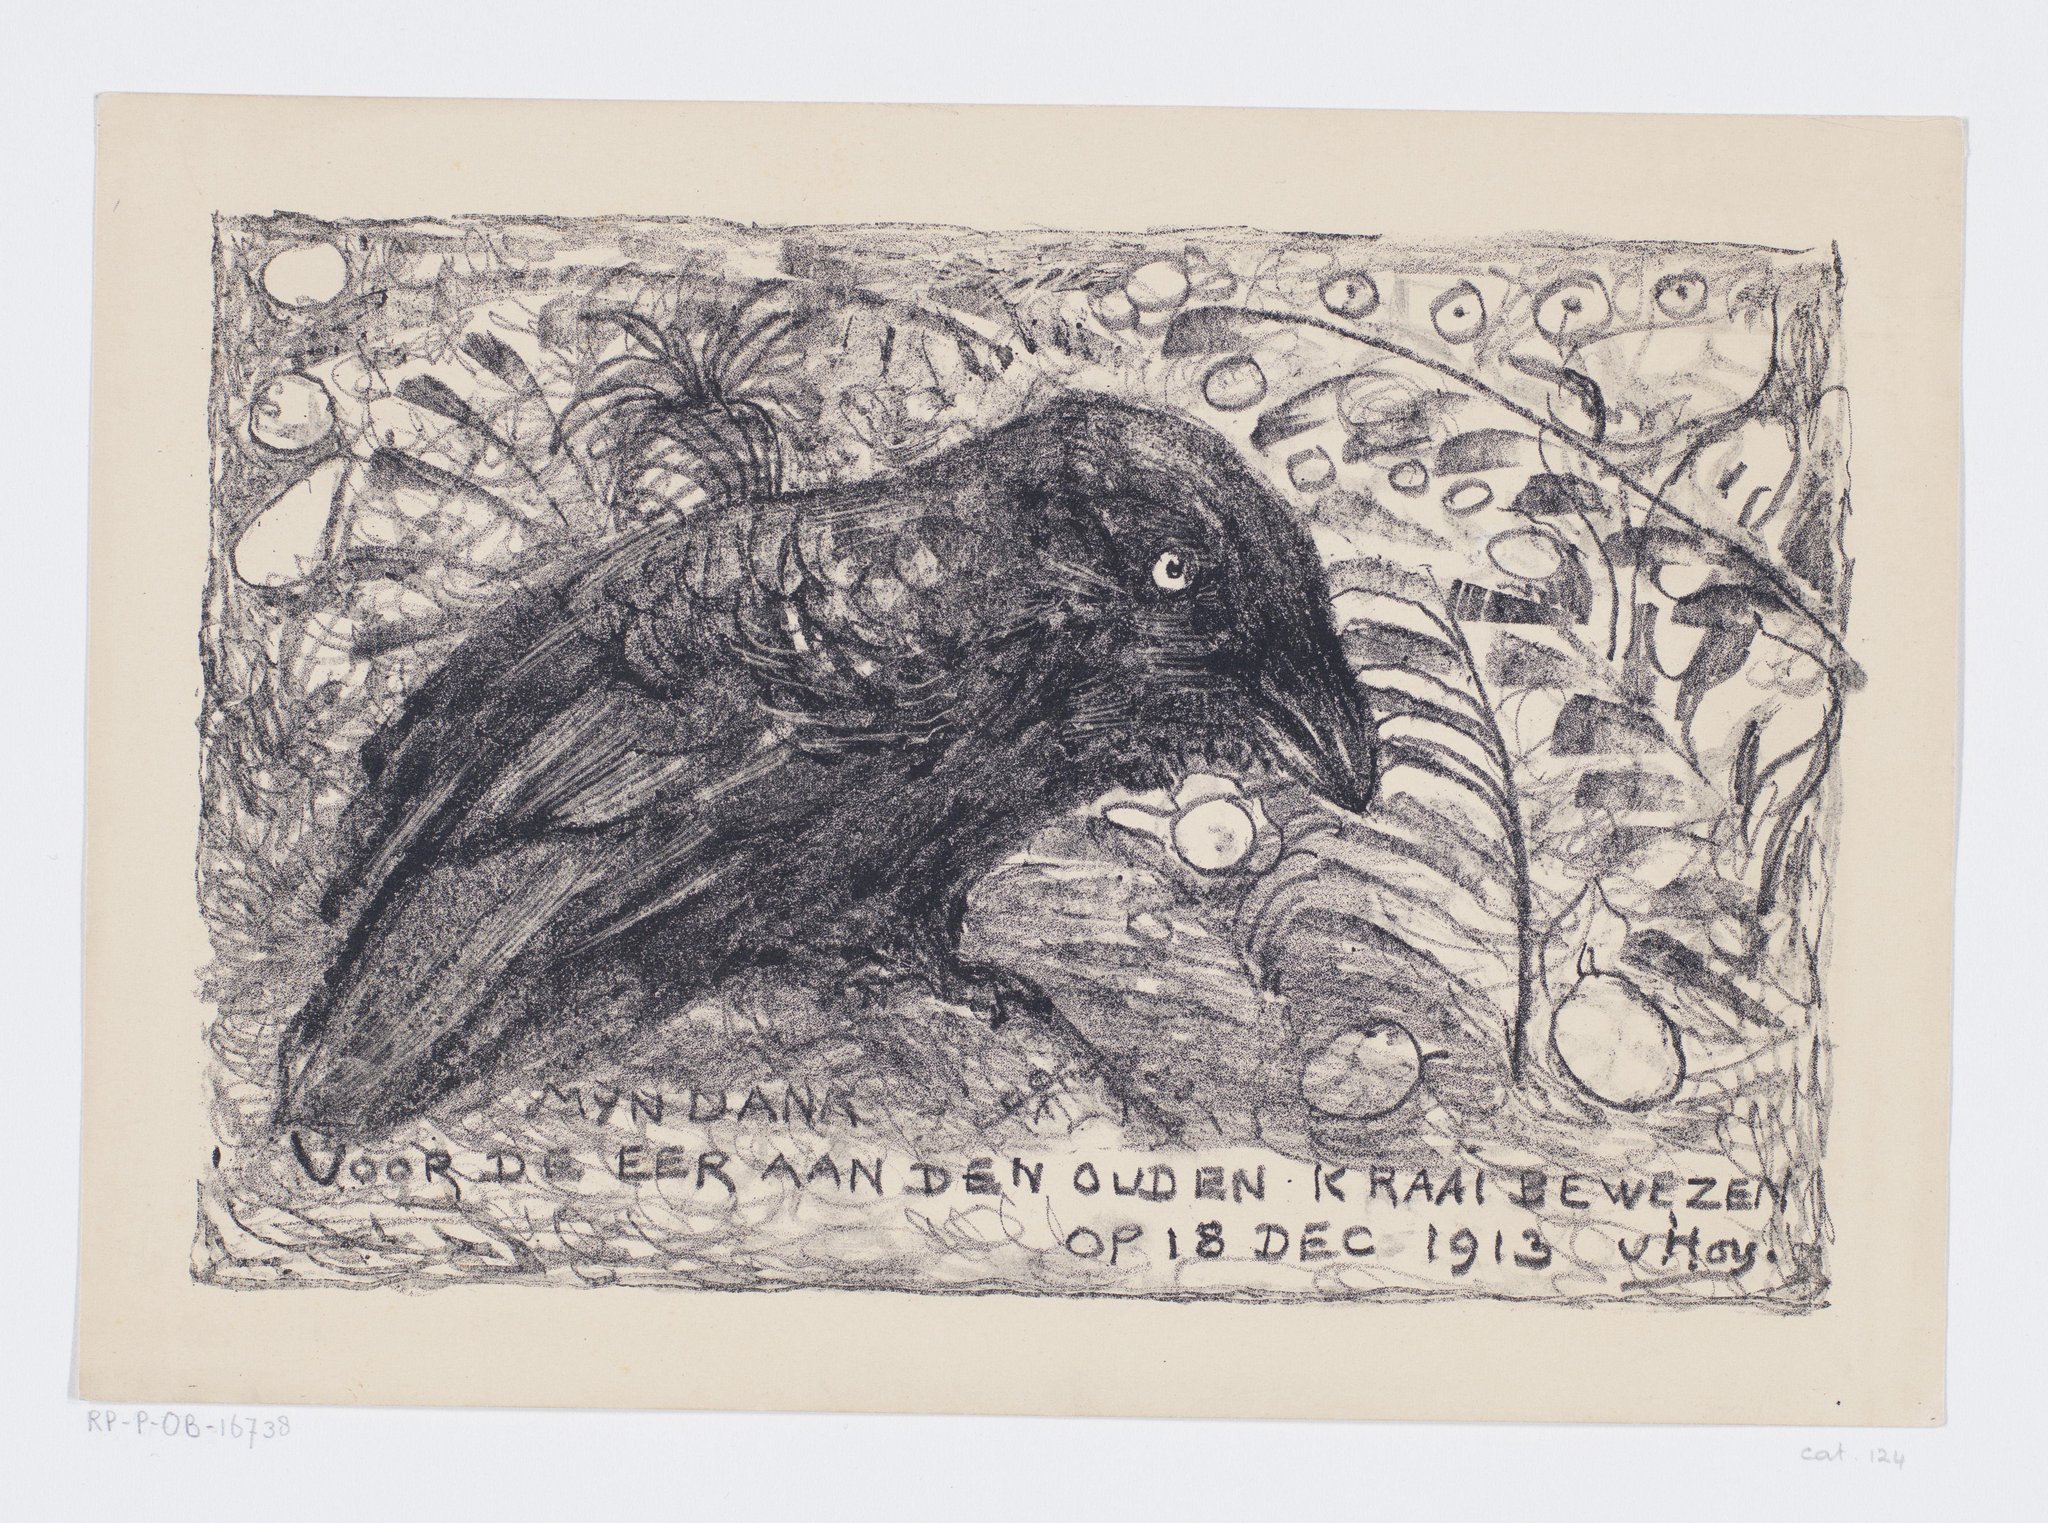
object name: print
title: Kraai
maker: theo van hoytema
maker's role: draughtsman, painter, print maker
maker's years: 1863-1917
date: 1913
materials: paper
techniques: lithograph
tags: song-birds: crow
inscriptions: collector's mark: Lugt 2228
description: Een kraai met daaronder de tekst 'Mijn dank voor de eer aan den ouden kraai bewezen op 18 dec 1913'.